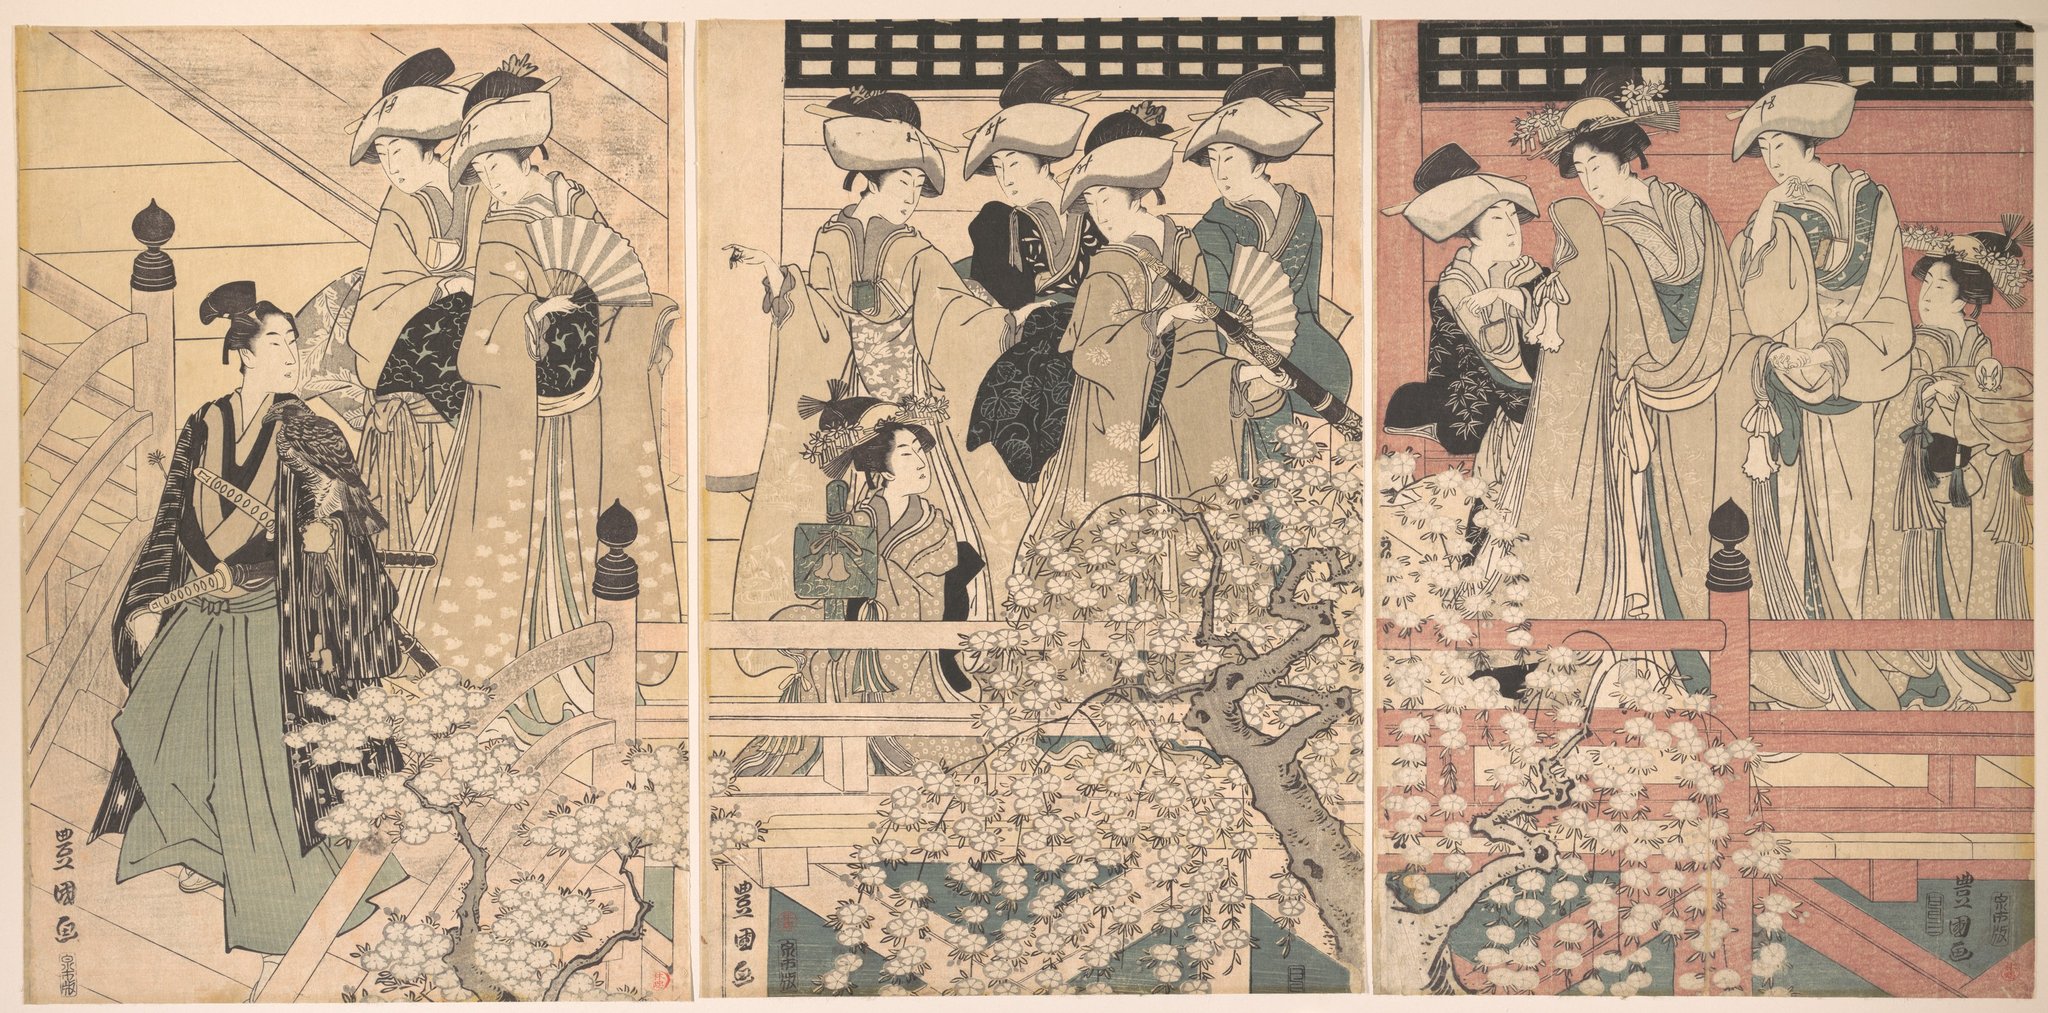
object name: print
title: Beauties on a Veranda among Cherry Blossoms from which a Samurai is Departing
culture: japanese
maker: utagawa toyokuni i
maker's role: artist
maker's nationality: japanese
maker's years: 1769-1825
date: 1800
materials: ink, paper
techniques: woodblock print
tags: samurai,men,women